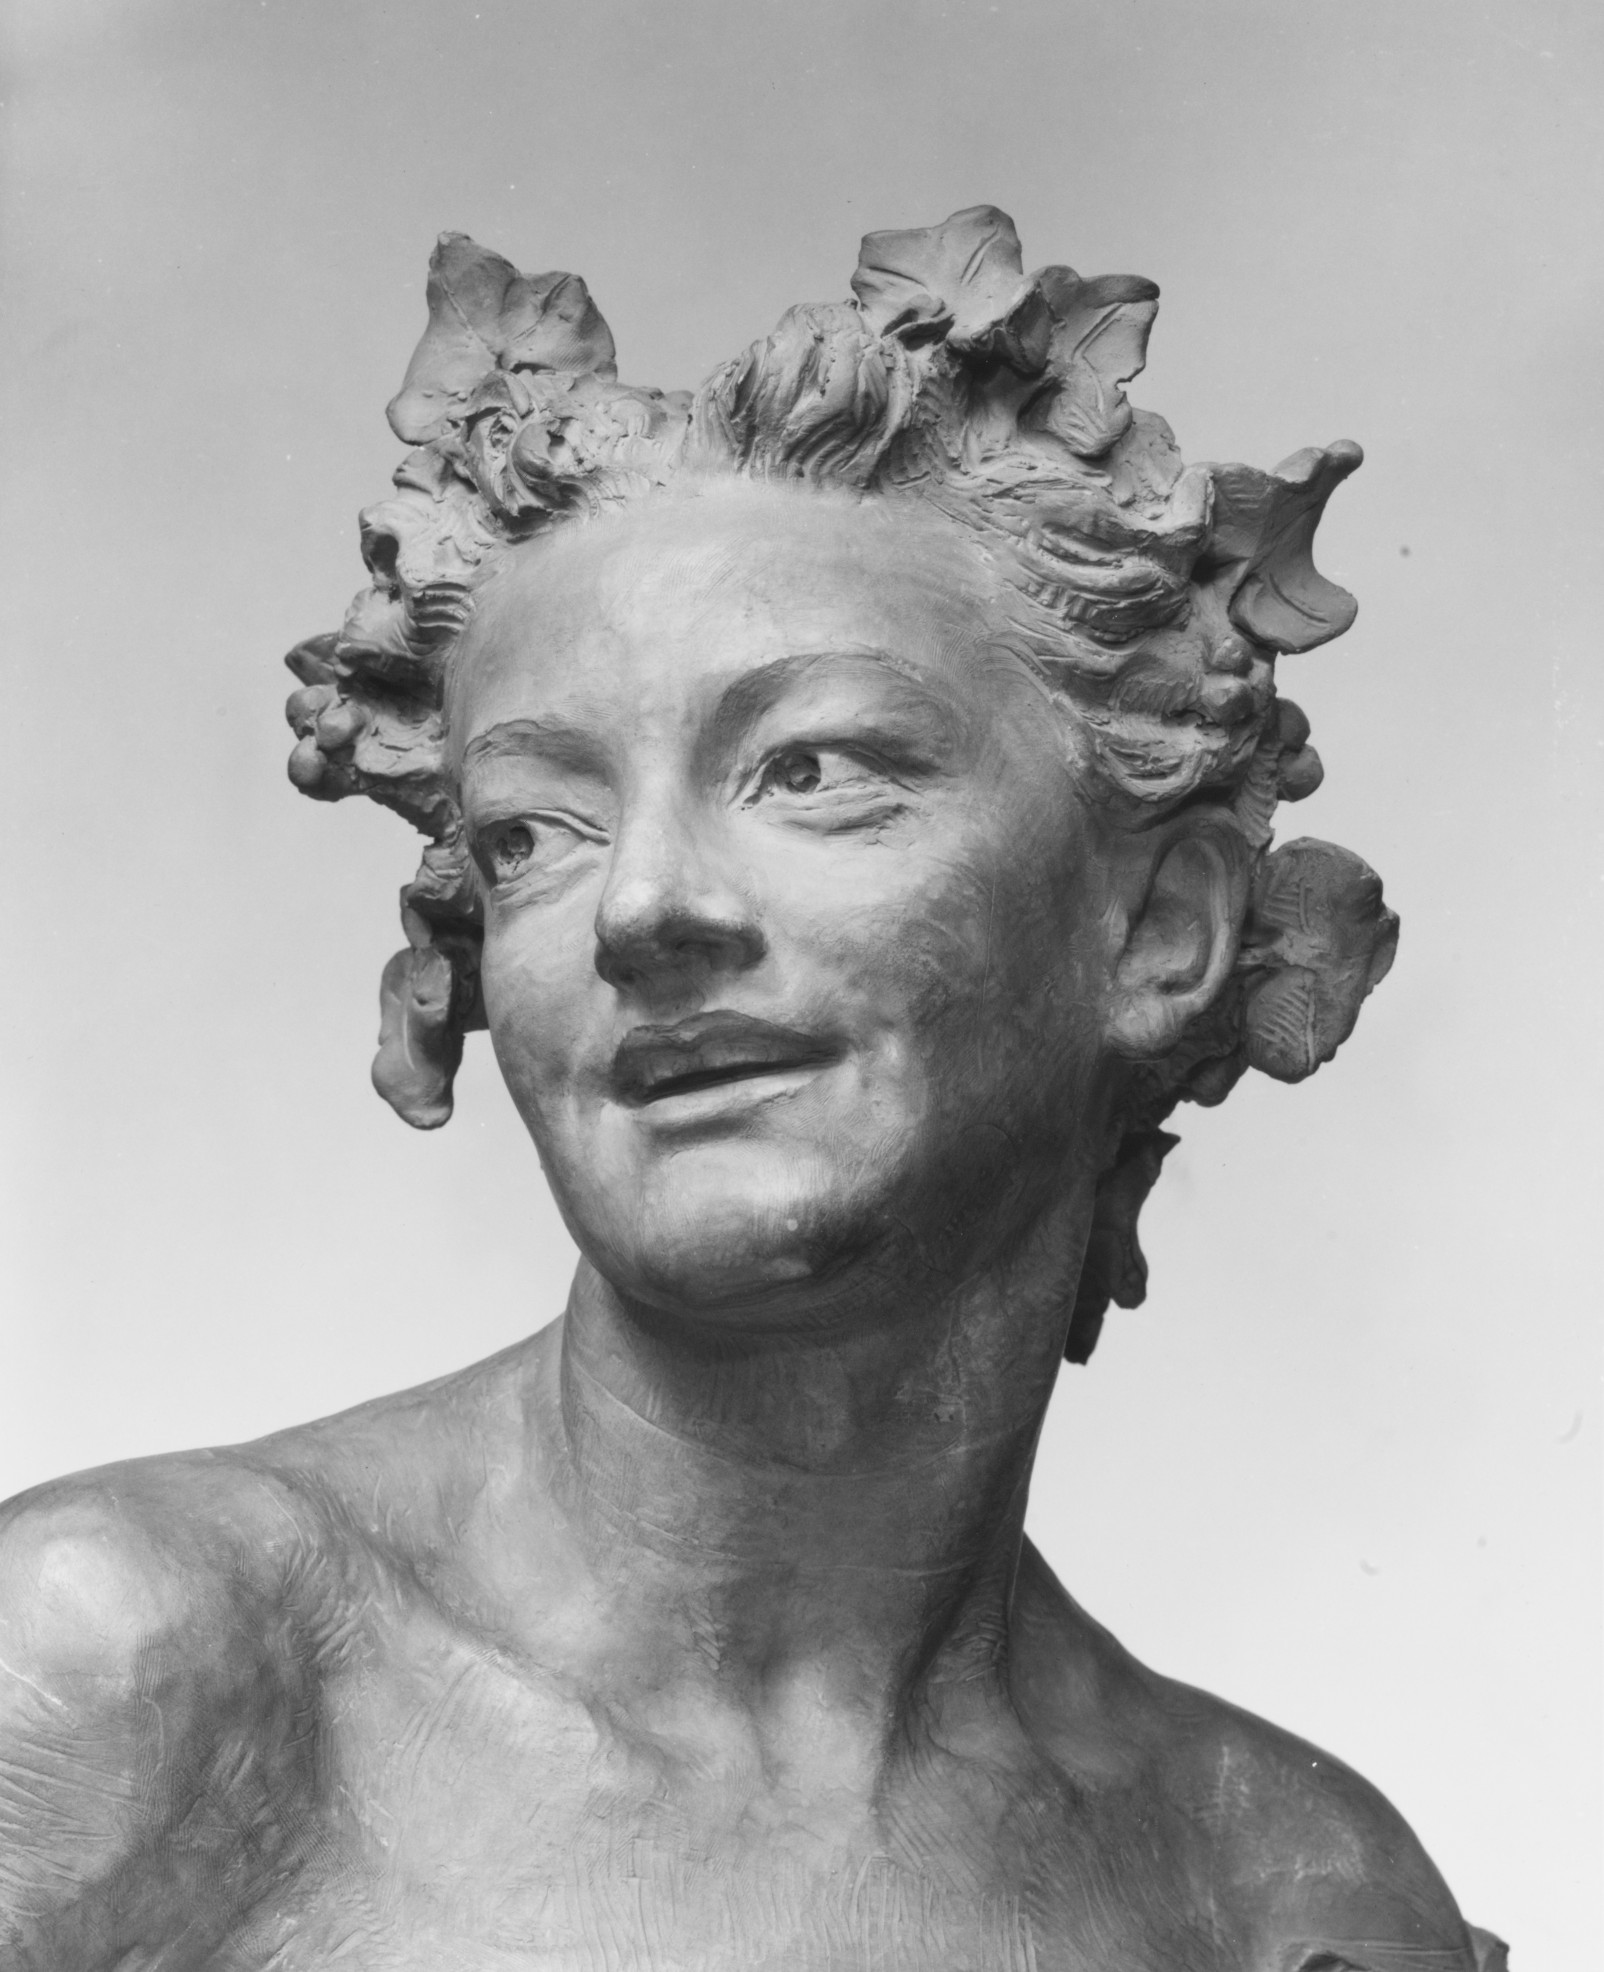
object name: bust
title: Bacchante with vine leaves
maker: jean-baptiste carpeaux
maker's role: artist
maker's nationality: french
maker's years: 1827-1875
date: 1872-1875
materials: marble, terracotta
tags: women,leaves,vines